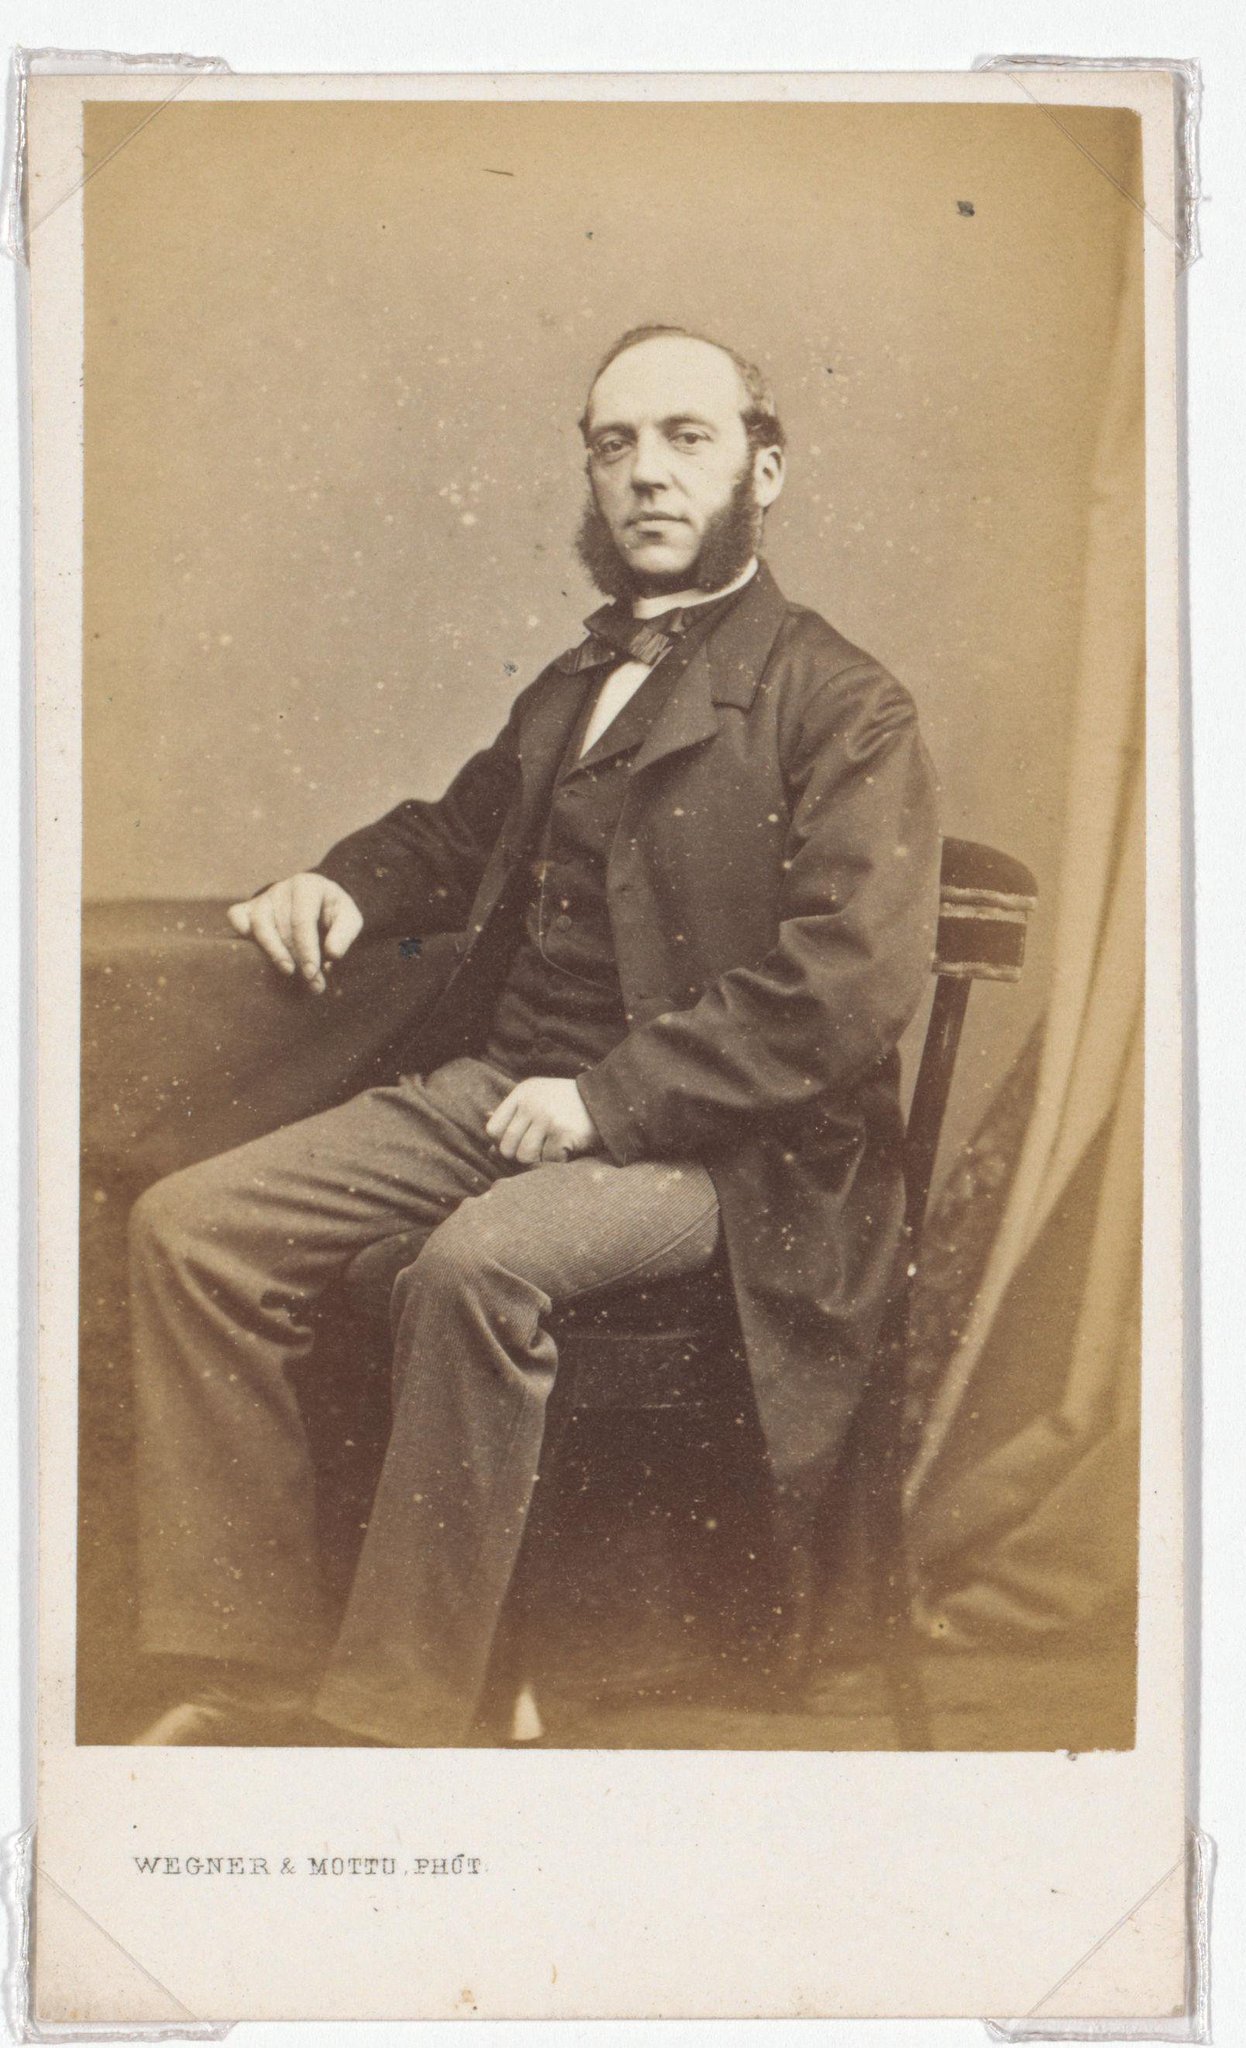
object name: photograph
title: Portret van N.W.P. Rauwenhoff, lid van de Koninklijke Nederlandsche Akademie van Wetenschappen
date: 1857-1864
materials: cardboard, paper, photographic support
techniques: albumen print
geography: amsterdam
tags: studio requisites ~ photographer, scholar, philosopher, historical persons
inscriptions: name: ‘N.W.P. Rauwenhoff Rotterdam’, address: ‘Prinsengracht BB. 439 Amsterdam’